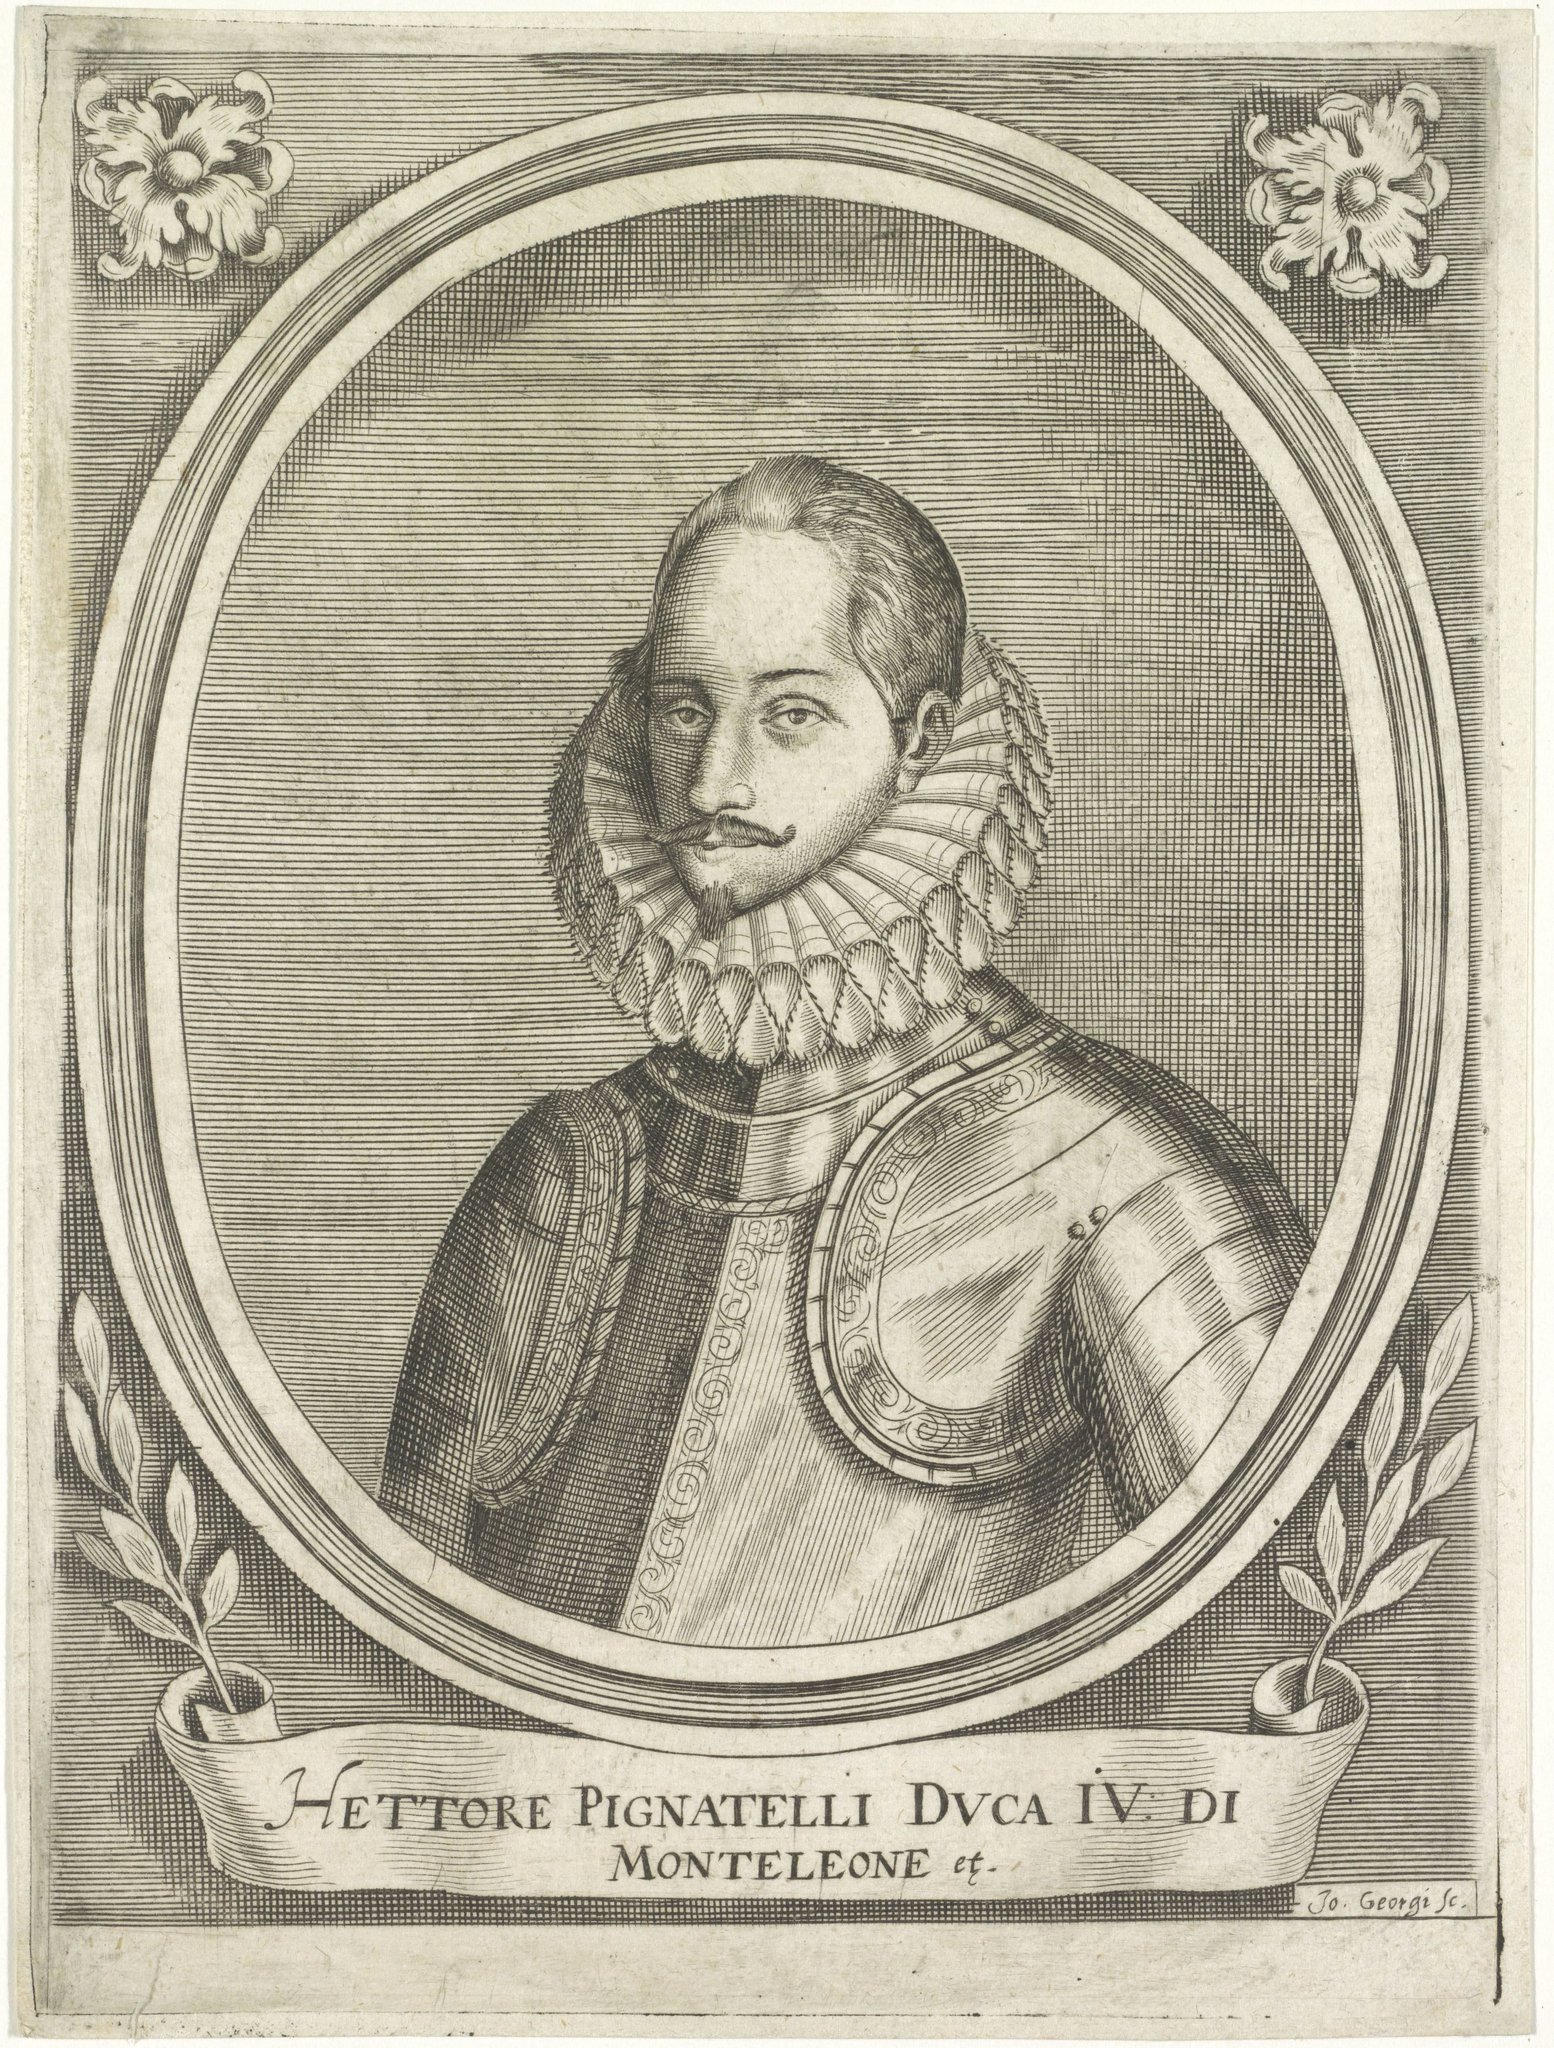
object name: print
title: Portret van Ettore Pignatelli IV, hertog van Monteleone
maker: giovanni georgi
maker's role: print maker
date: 1600-1699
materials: paper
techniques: engraving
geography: italy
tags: historical persons, ruler, sovereign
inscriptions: collector's mark: Lugt 2228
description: Linksboven en rechtsboven een wapenschild.